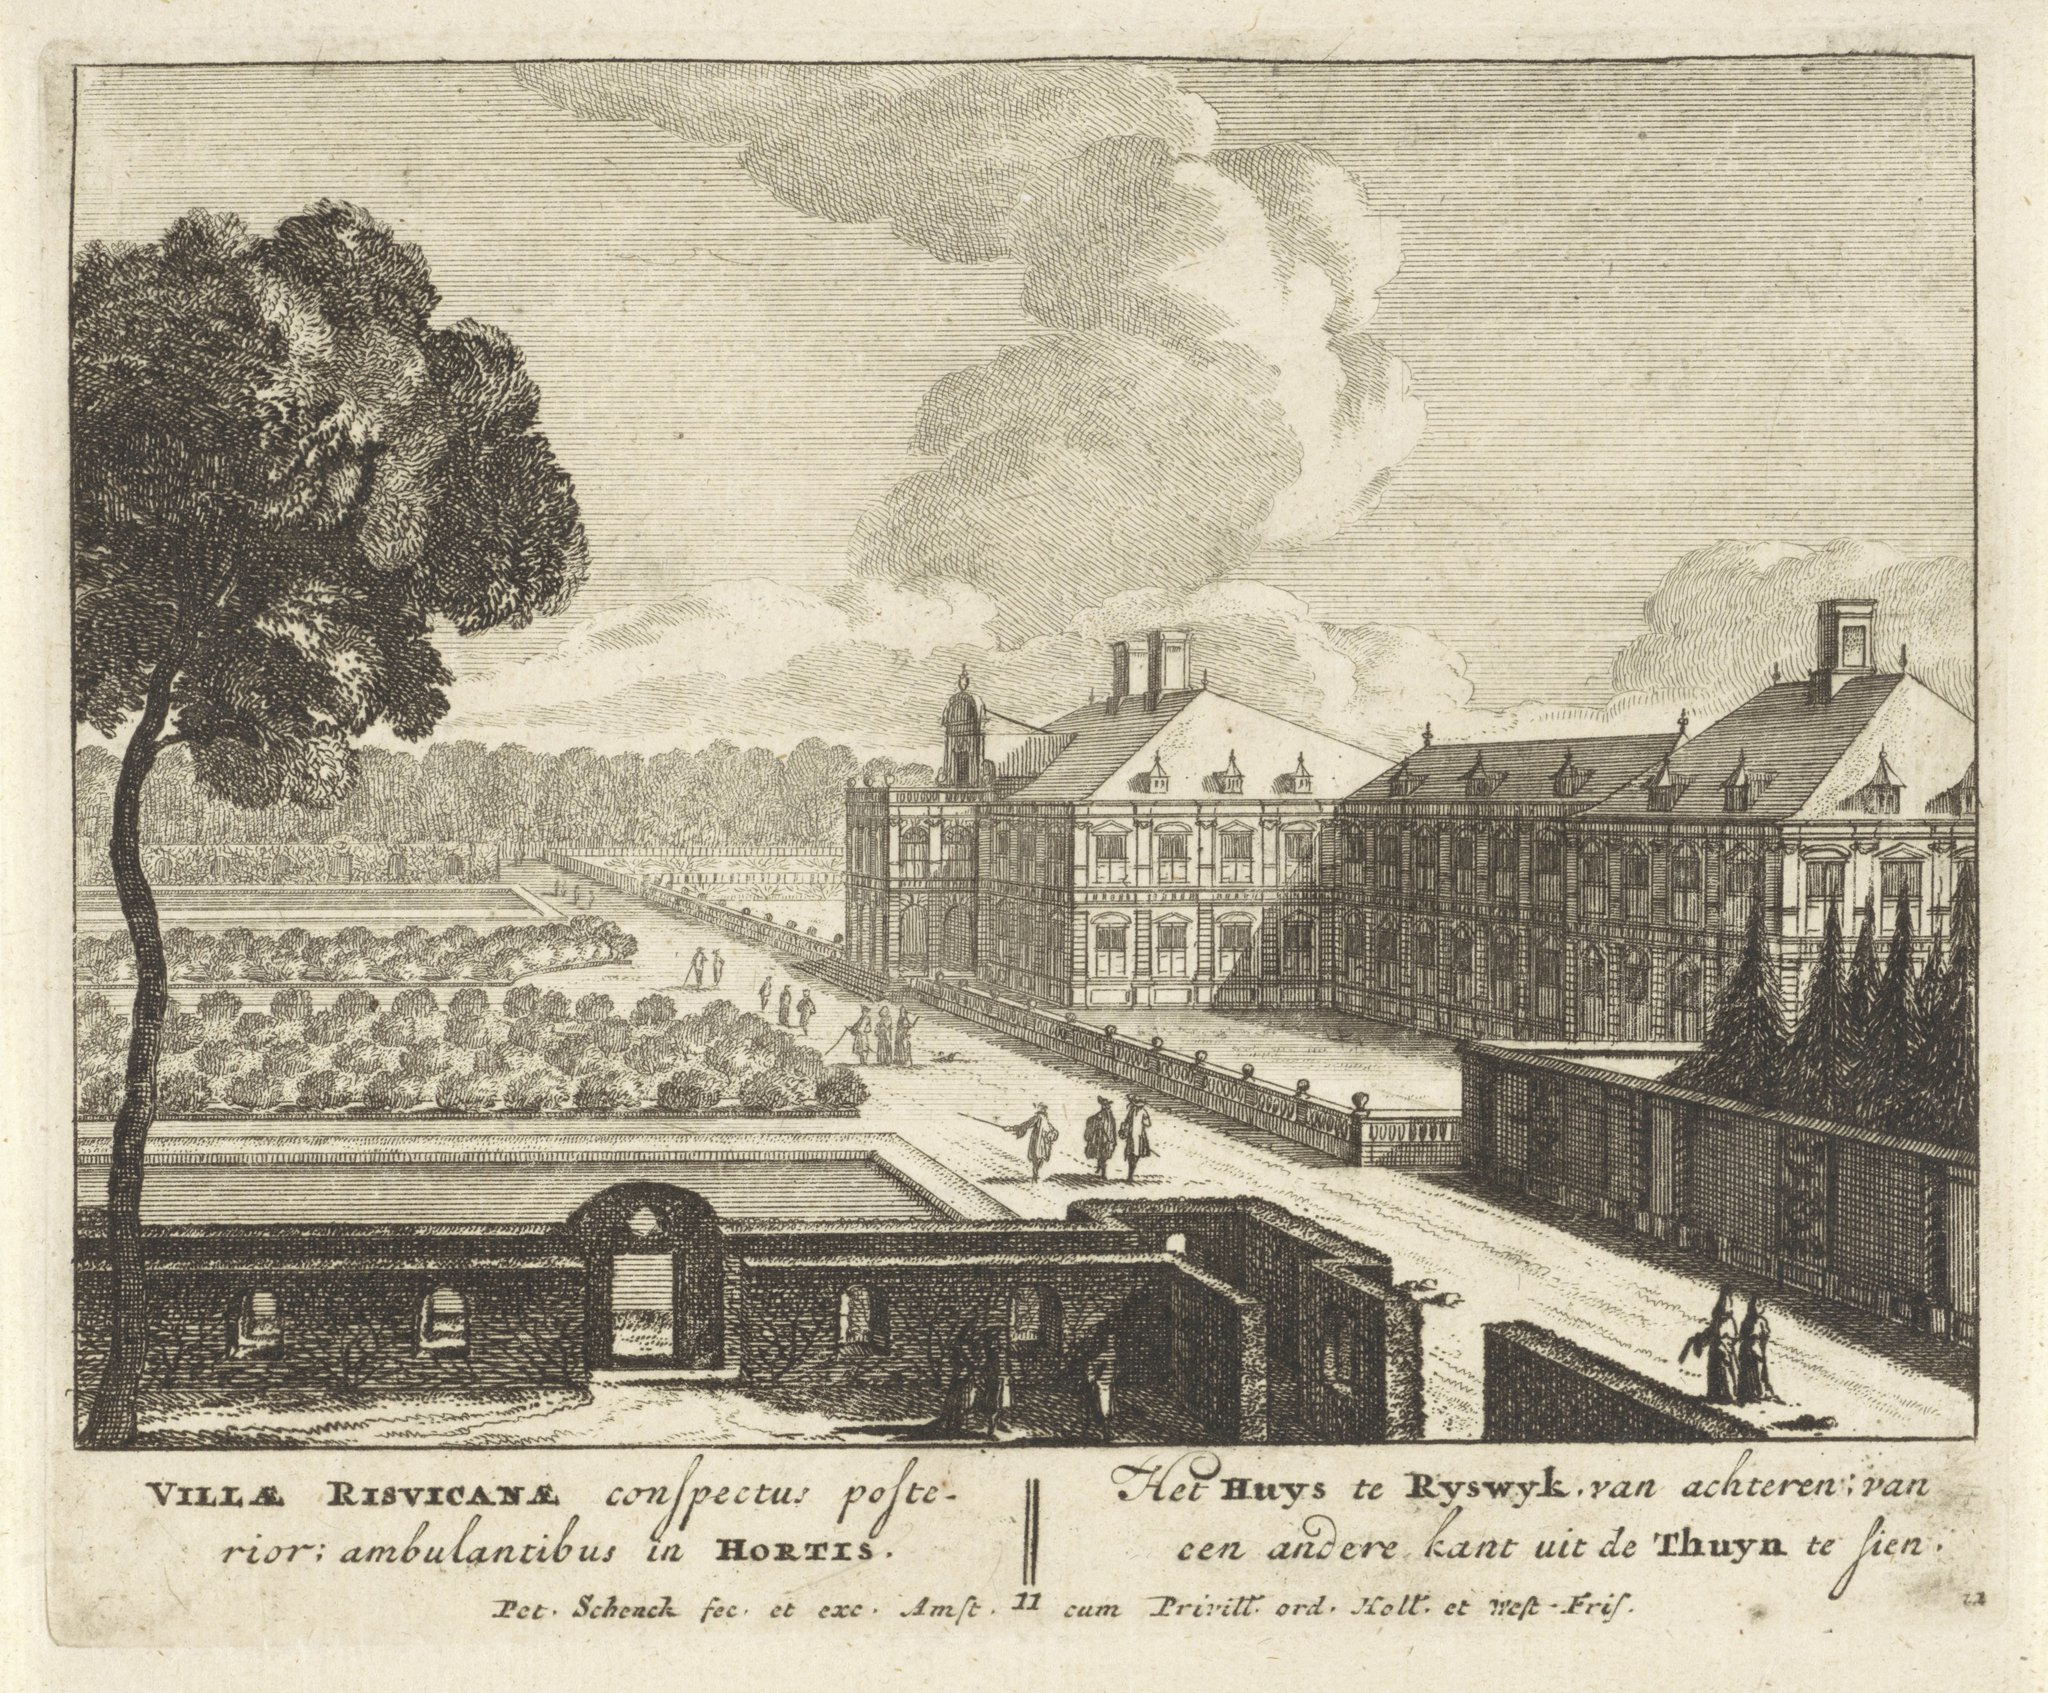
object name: print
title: Het Huys te Ryswyk van achteren van een andere kant uit de Tuyn te sien / Villae Risvicanae conspectus posterior (...)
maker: pieter schenk (i)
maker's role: print maker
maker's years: 1660-1711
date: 1697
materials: paper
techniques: etching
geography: amsterdam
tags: huis ter nieuburch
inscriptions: collector's mark: Lugt 2228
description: Gezicht schuin op de achterzijde van Huis ter Nieuburch te Rijswijk.